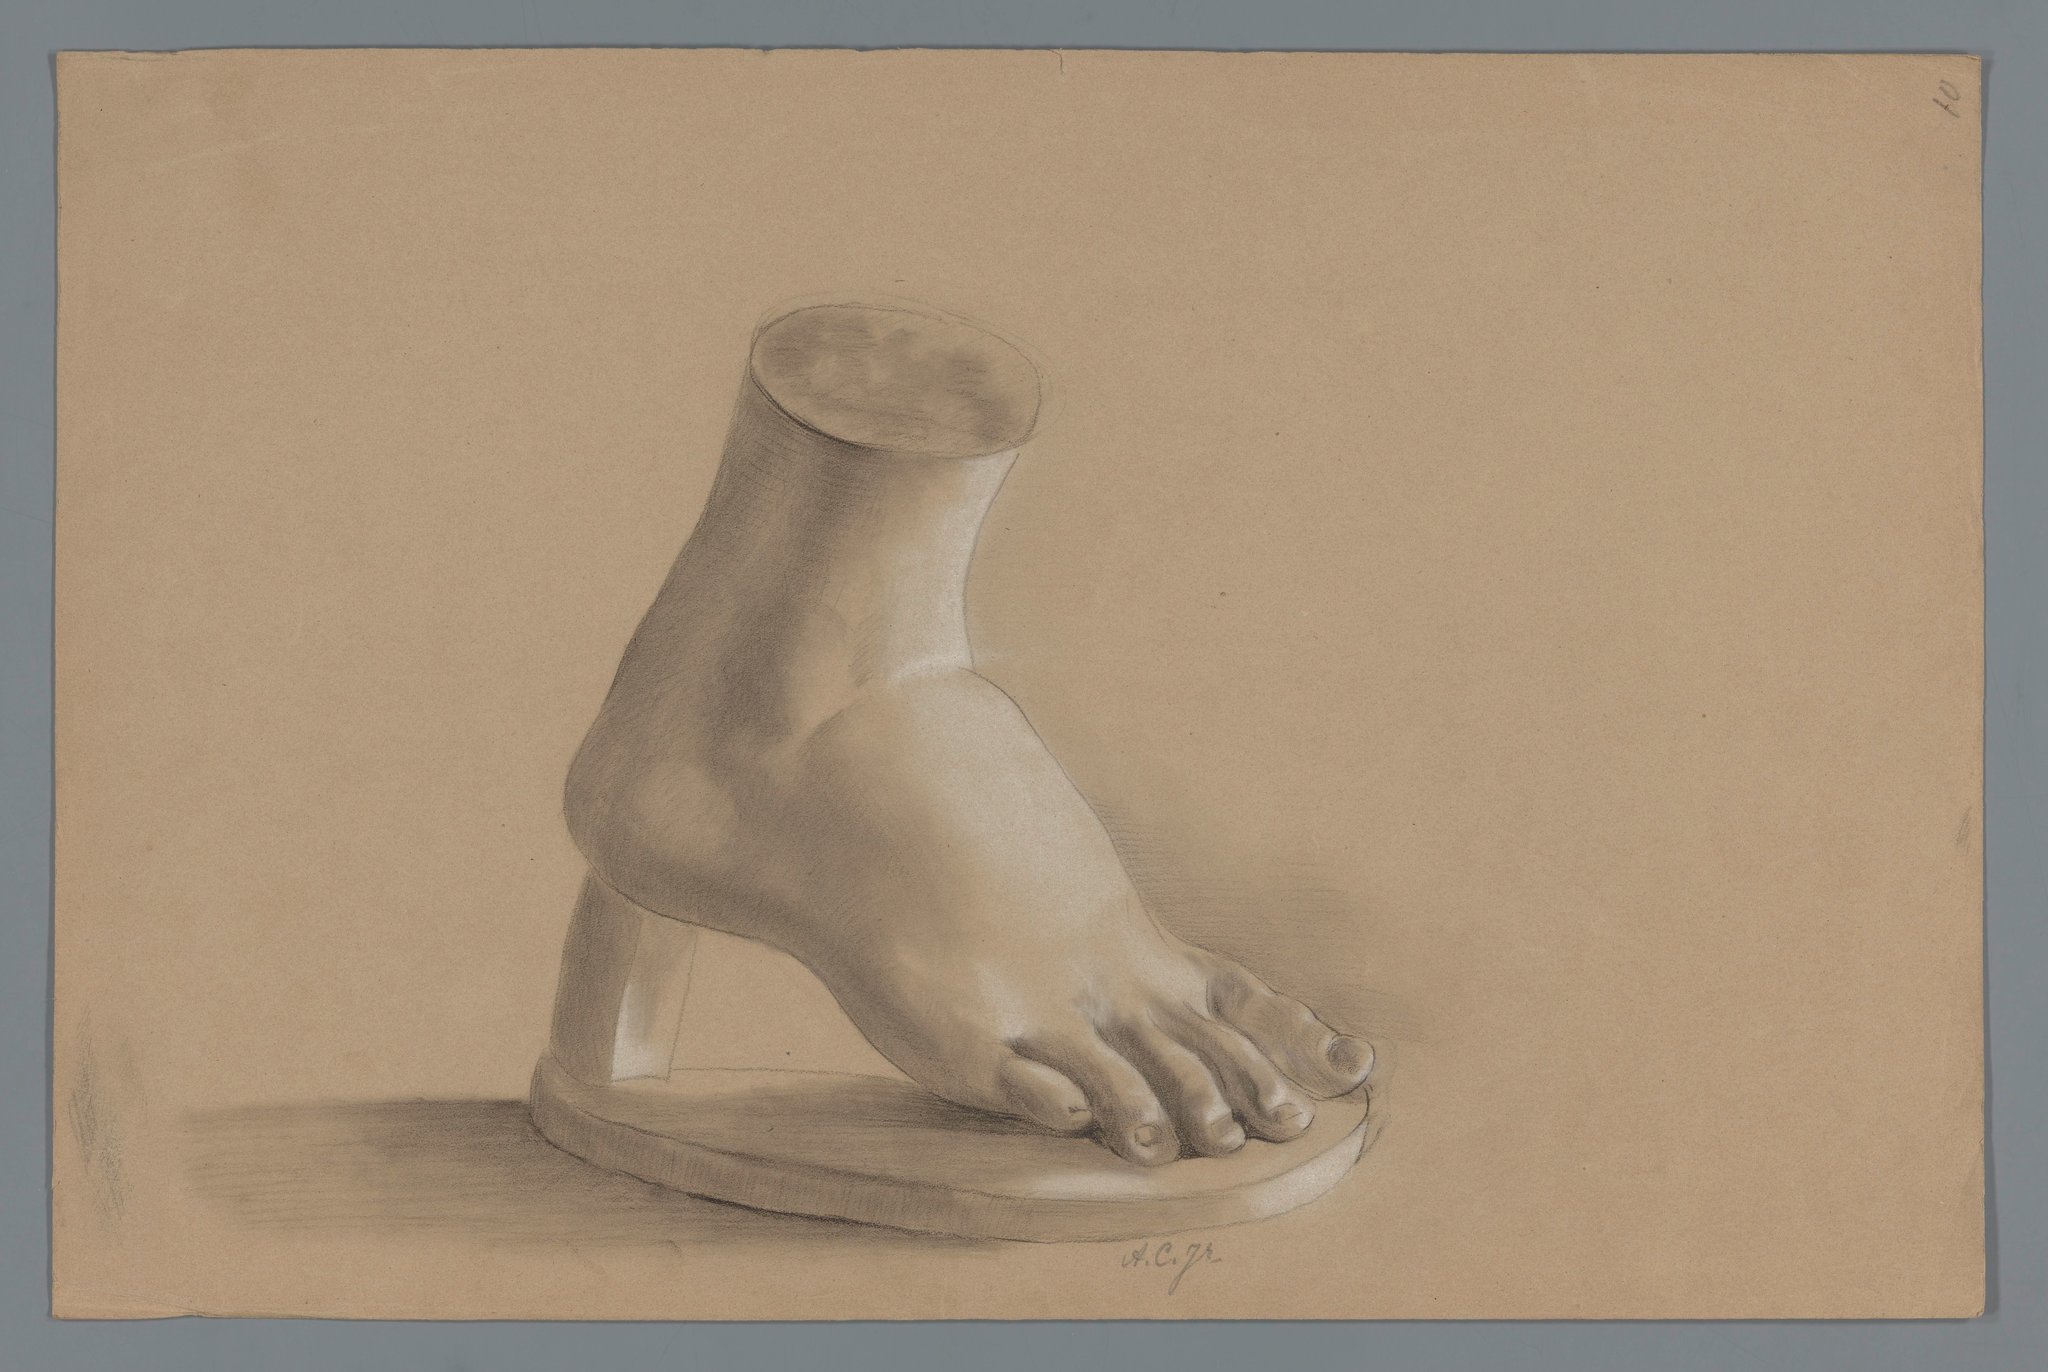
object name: drawing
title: Gipsmodel van een voet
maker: alexander cranendoncq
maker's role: draughtsman, print maker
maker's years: 1799-1869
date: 1800-1900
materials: chalk, paper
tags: piece of sculpture, reproduction of a piece of sculpture (+ reproduction ~ work of art), foot